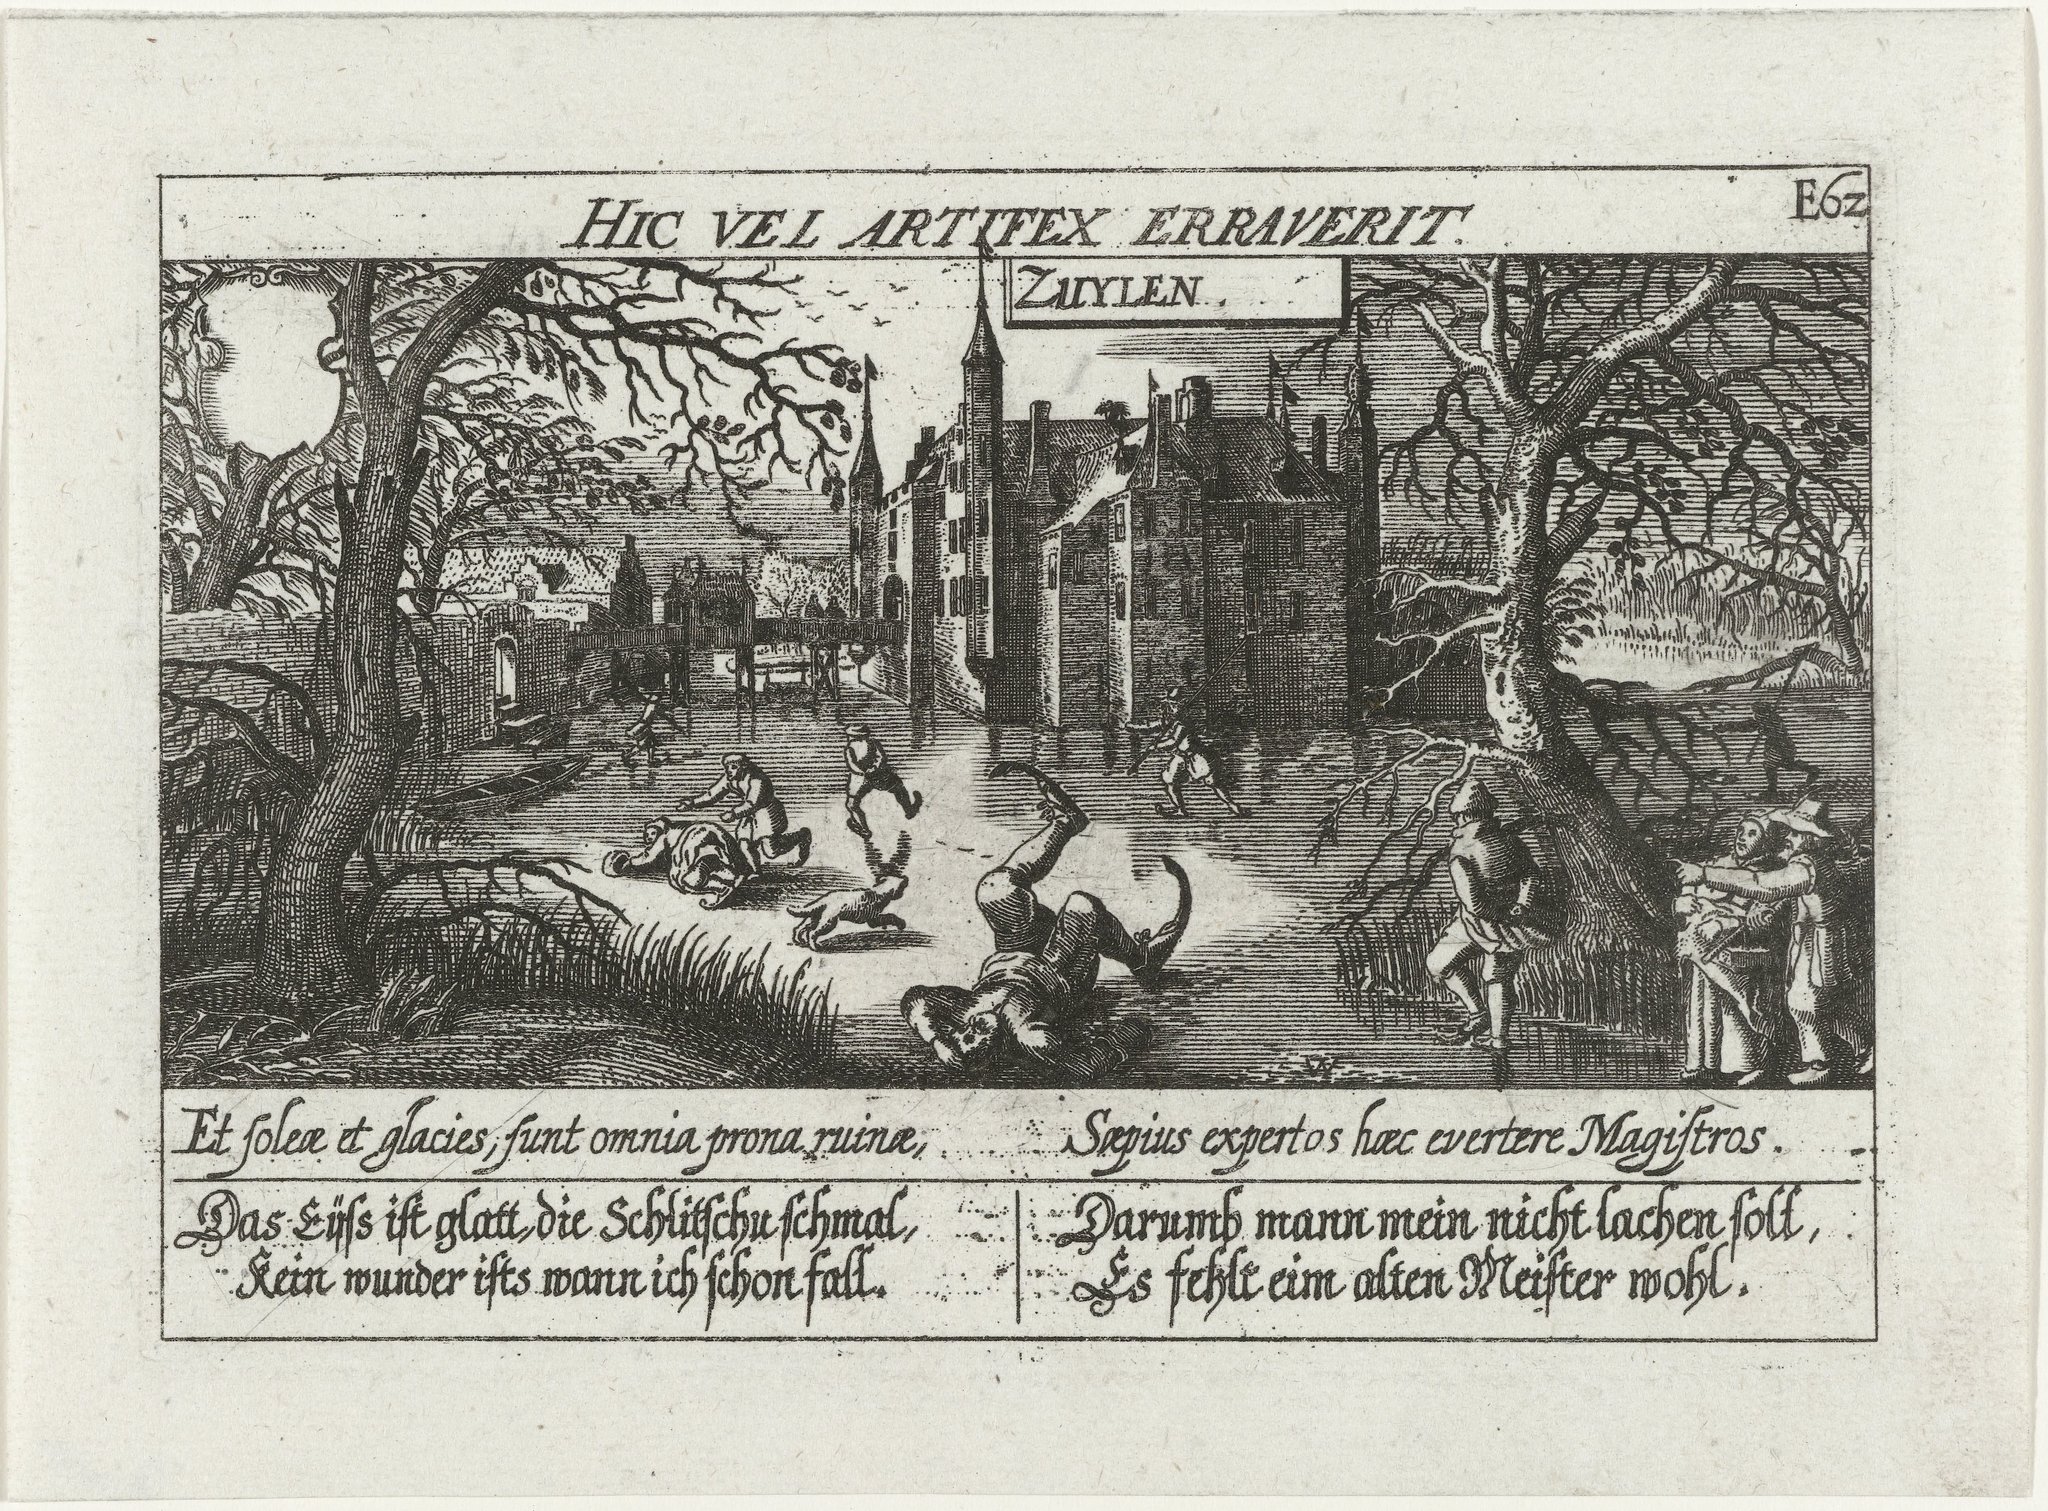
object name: print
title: Hic vel artifex erraverit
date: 1620-1650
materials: paper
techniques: engraving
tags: castle, skates (winter sports)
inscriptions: collector's mark: Lugt 2228, collector's mark: Lugt 2760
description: Schaatsende figuren in winterlandschap. Op de achtergrond een kasteel. Op de voorgrond een vallende schaatser. Linksboven een leeg wapenschild. Met onderschrift in Latijn en 4 regelig vers in het Duits: Das Eiss ist glatt..alten Meister wohl.